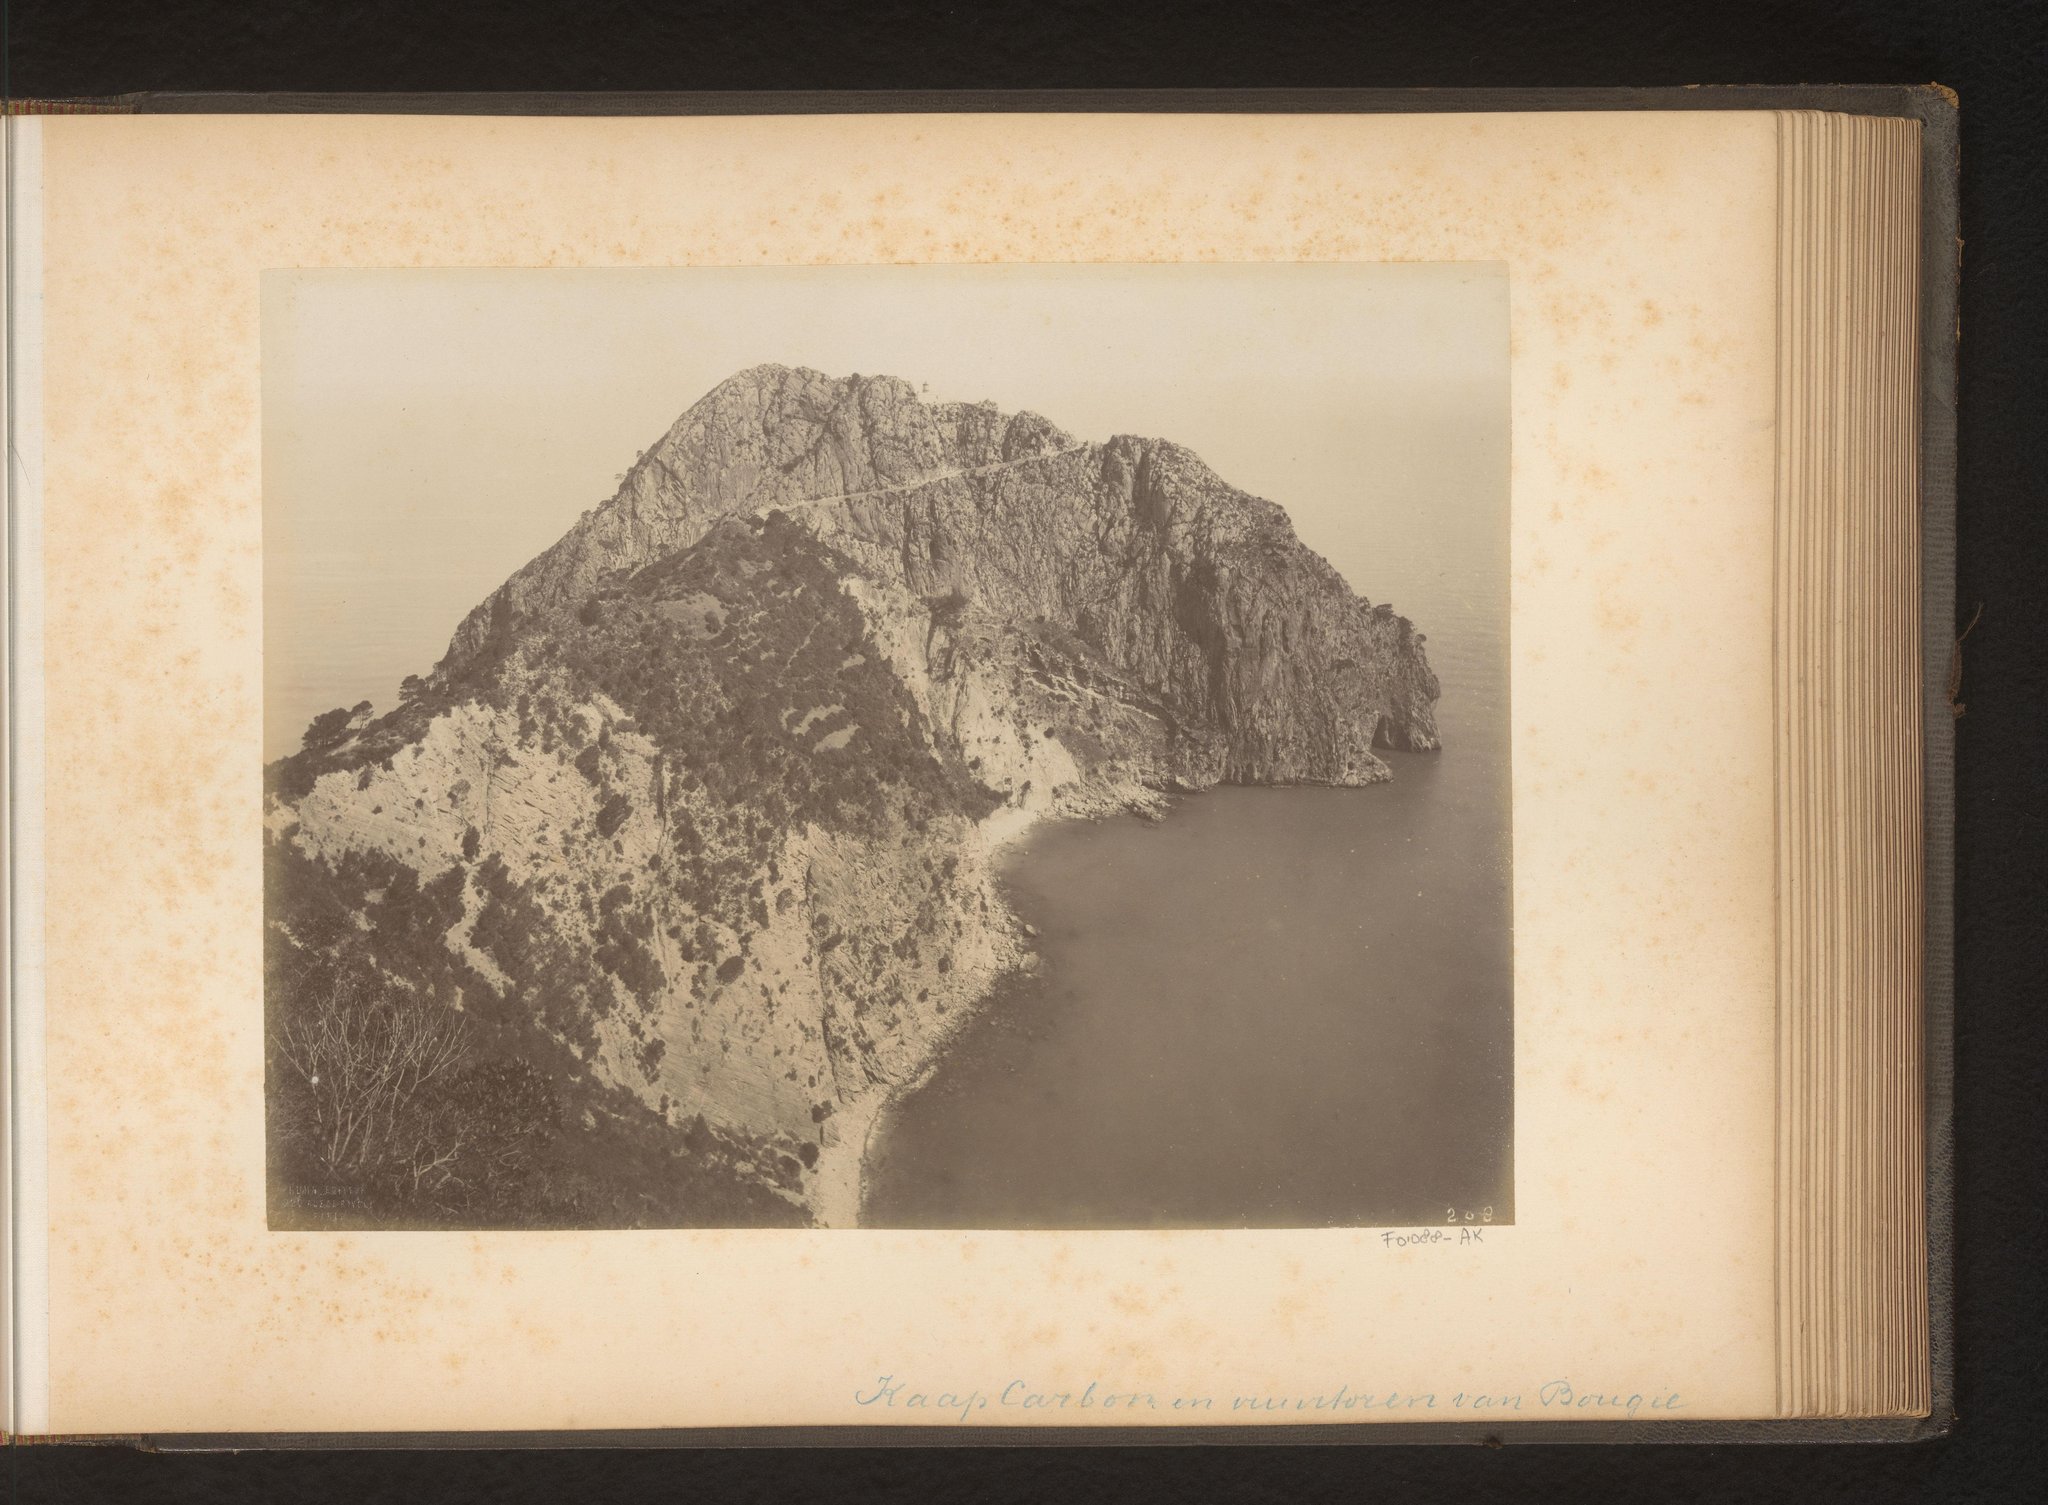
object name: album leaf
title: Vuurtoren op kaap Carbon te Algerije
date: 1880-1900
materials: photographic support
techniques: albumen print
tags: lighthouse, lightship, cape (coast)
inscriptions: annotation: ‘Kaap Carbon en vuurtoren van Bougie’, check stamp: ‘J. Kuhn Editeur/ 220 Rue de Rivoli Paris’, number: ‘208’